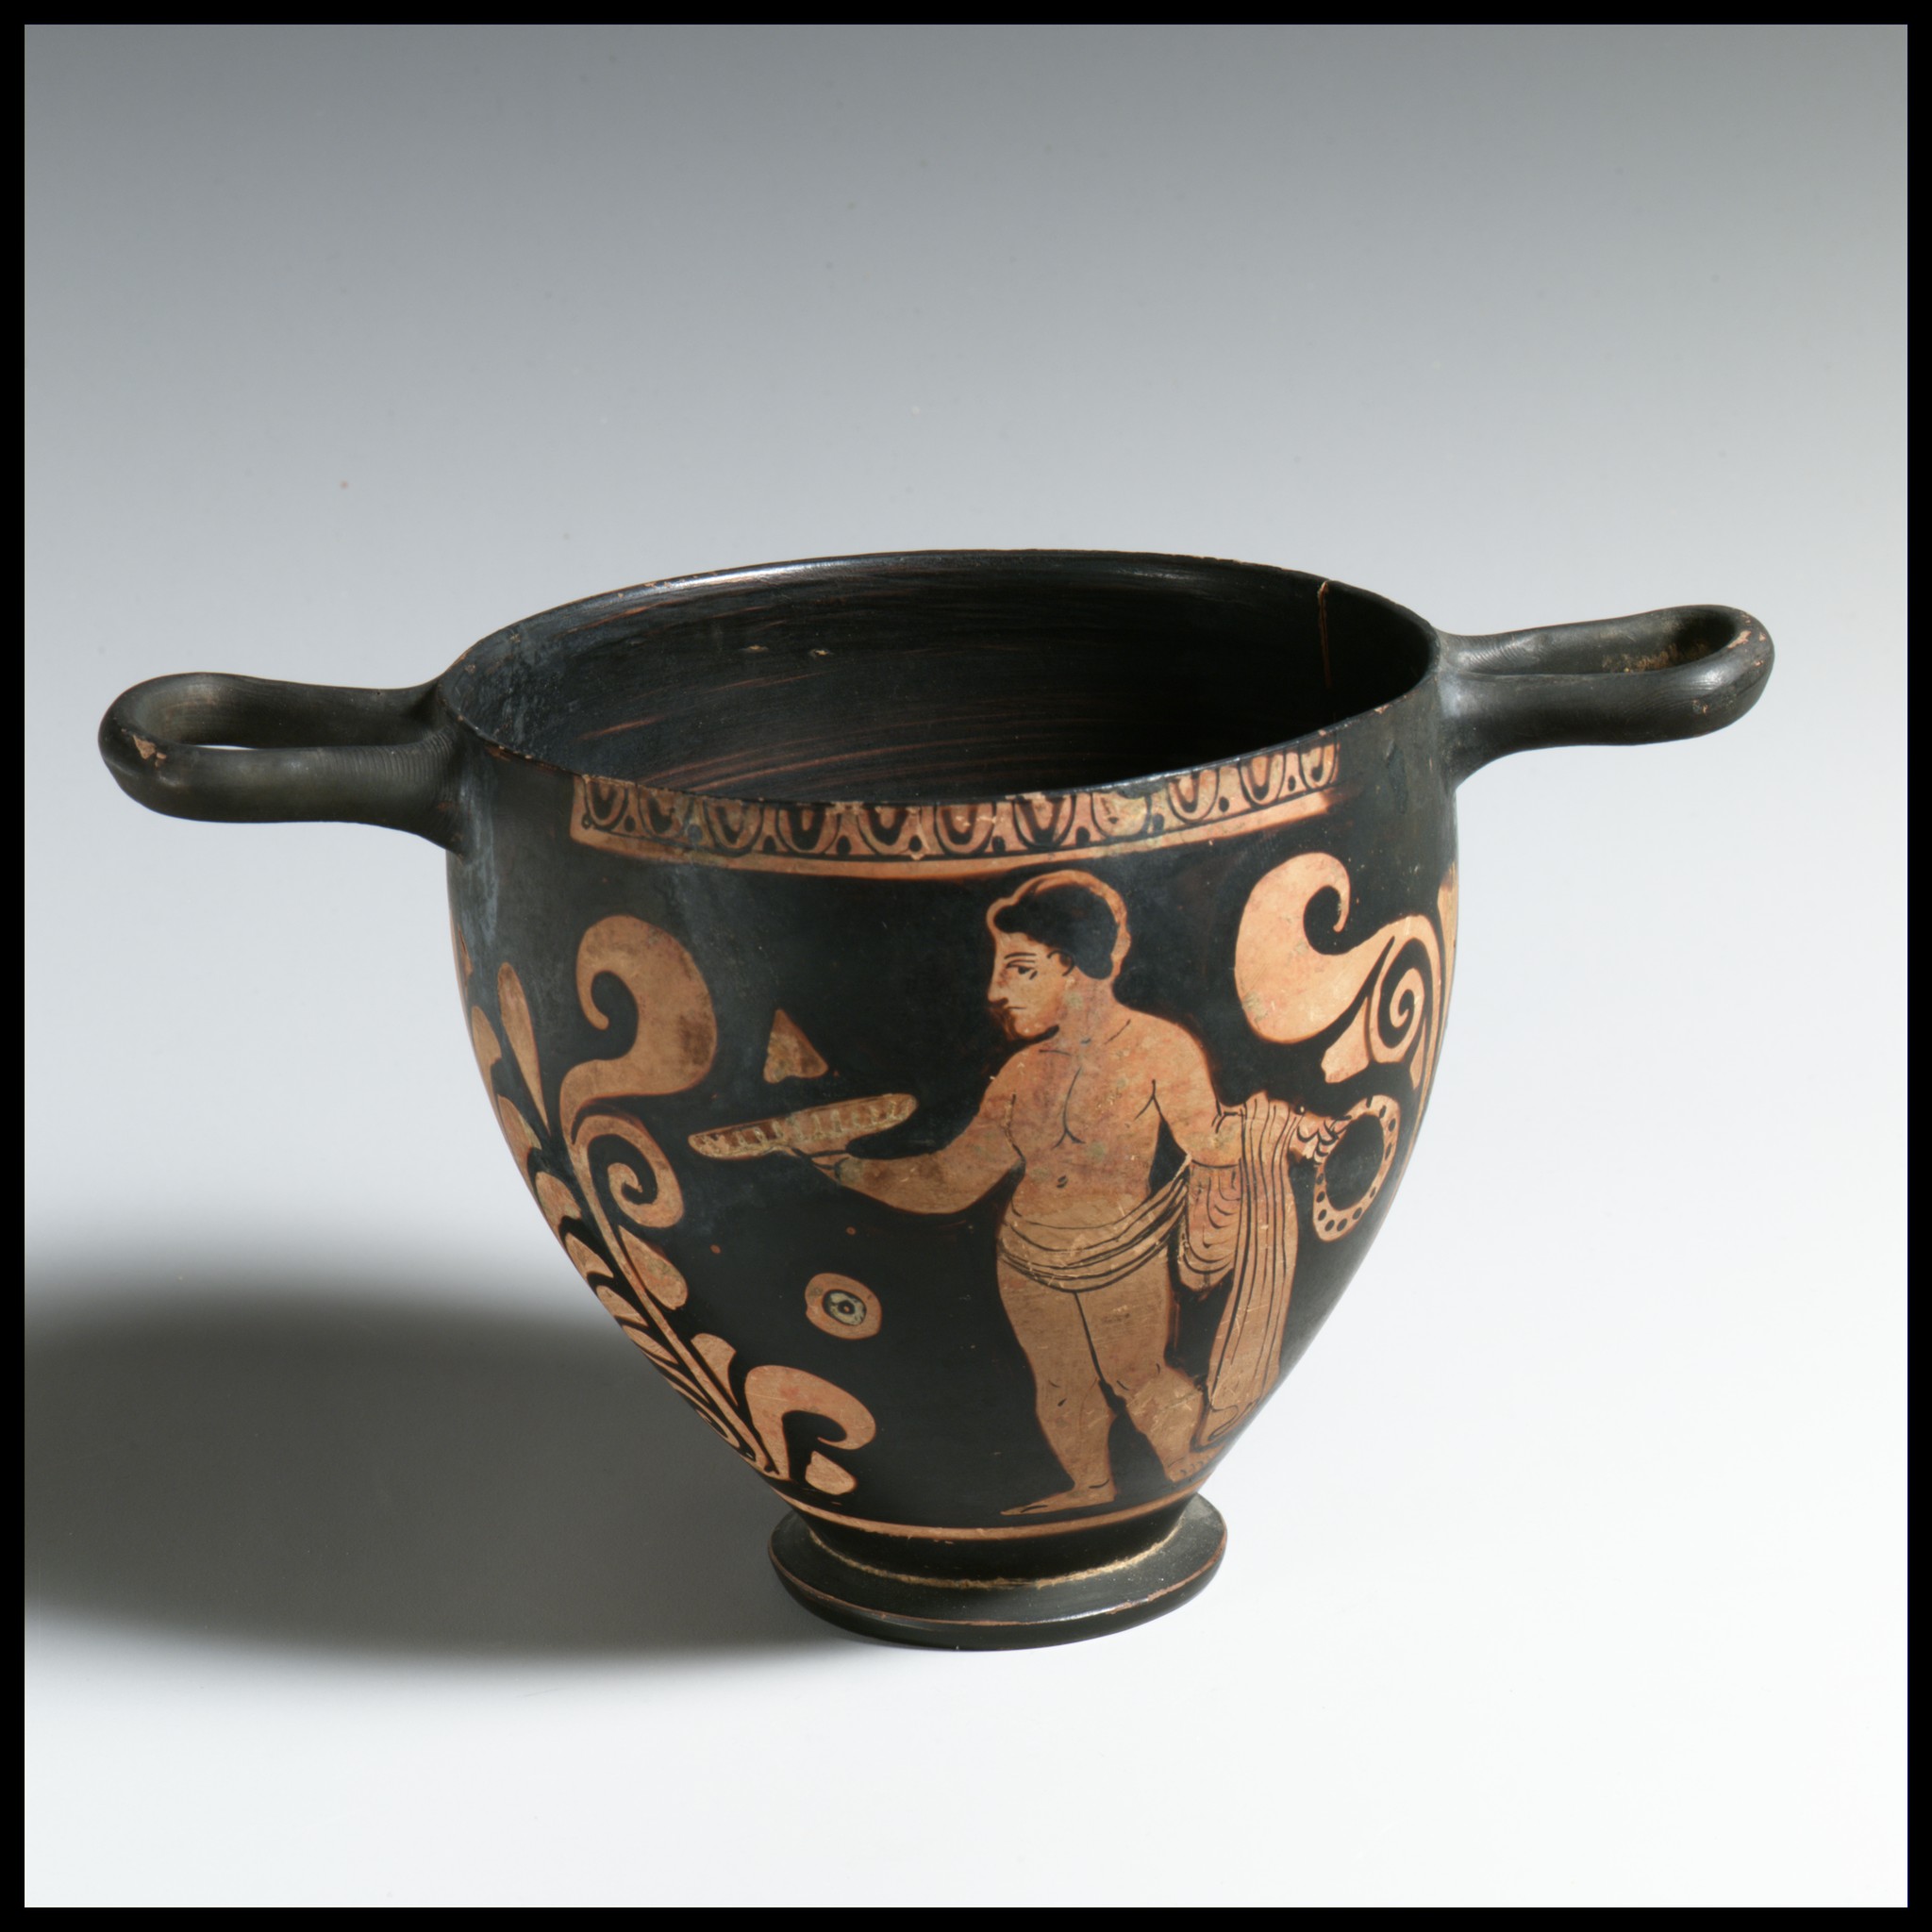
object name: skyphos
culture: greek, south italian, apulian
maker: group of altenburg 331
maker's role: artist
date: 350-325 BCE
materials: terracotta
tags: men